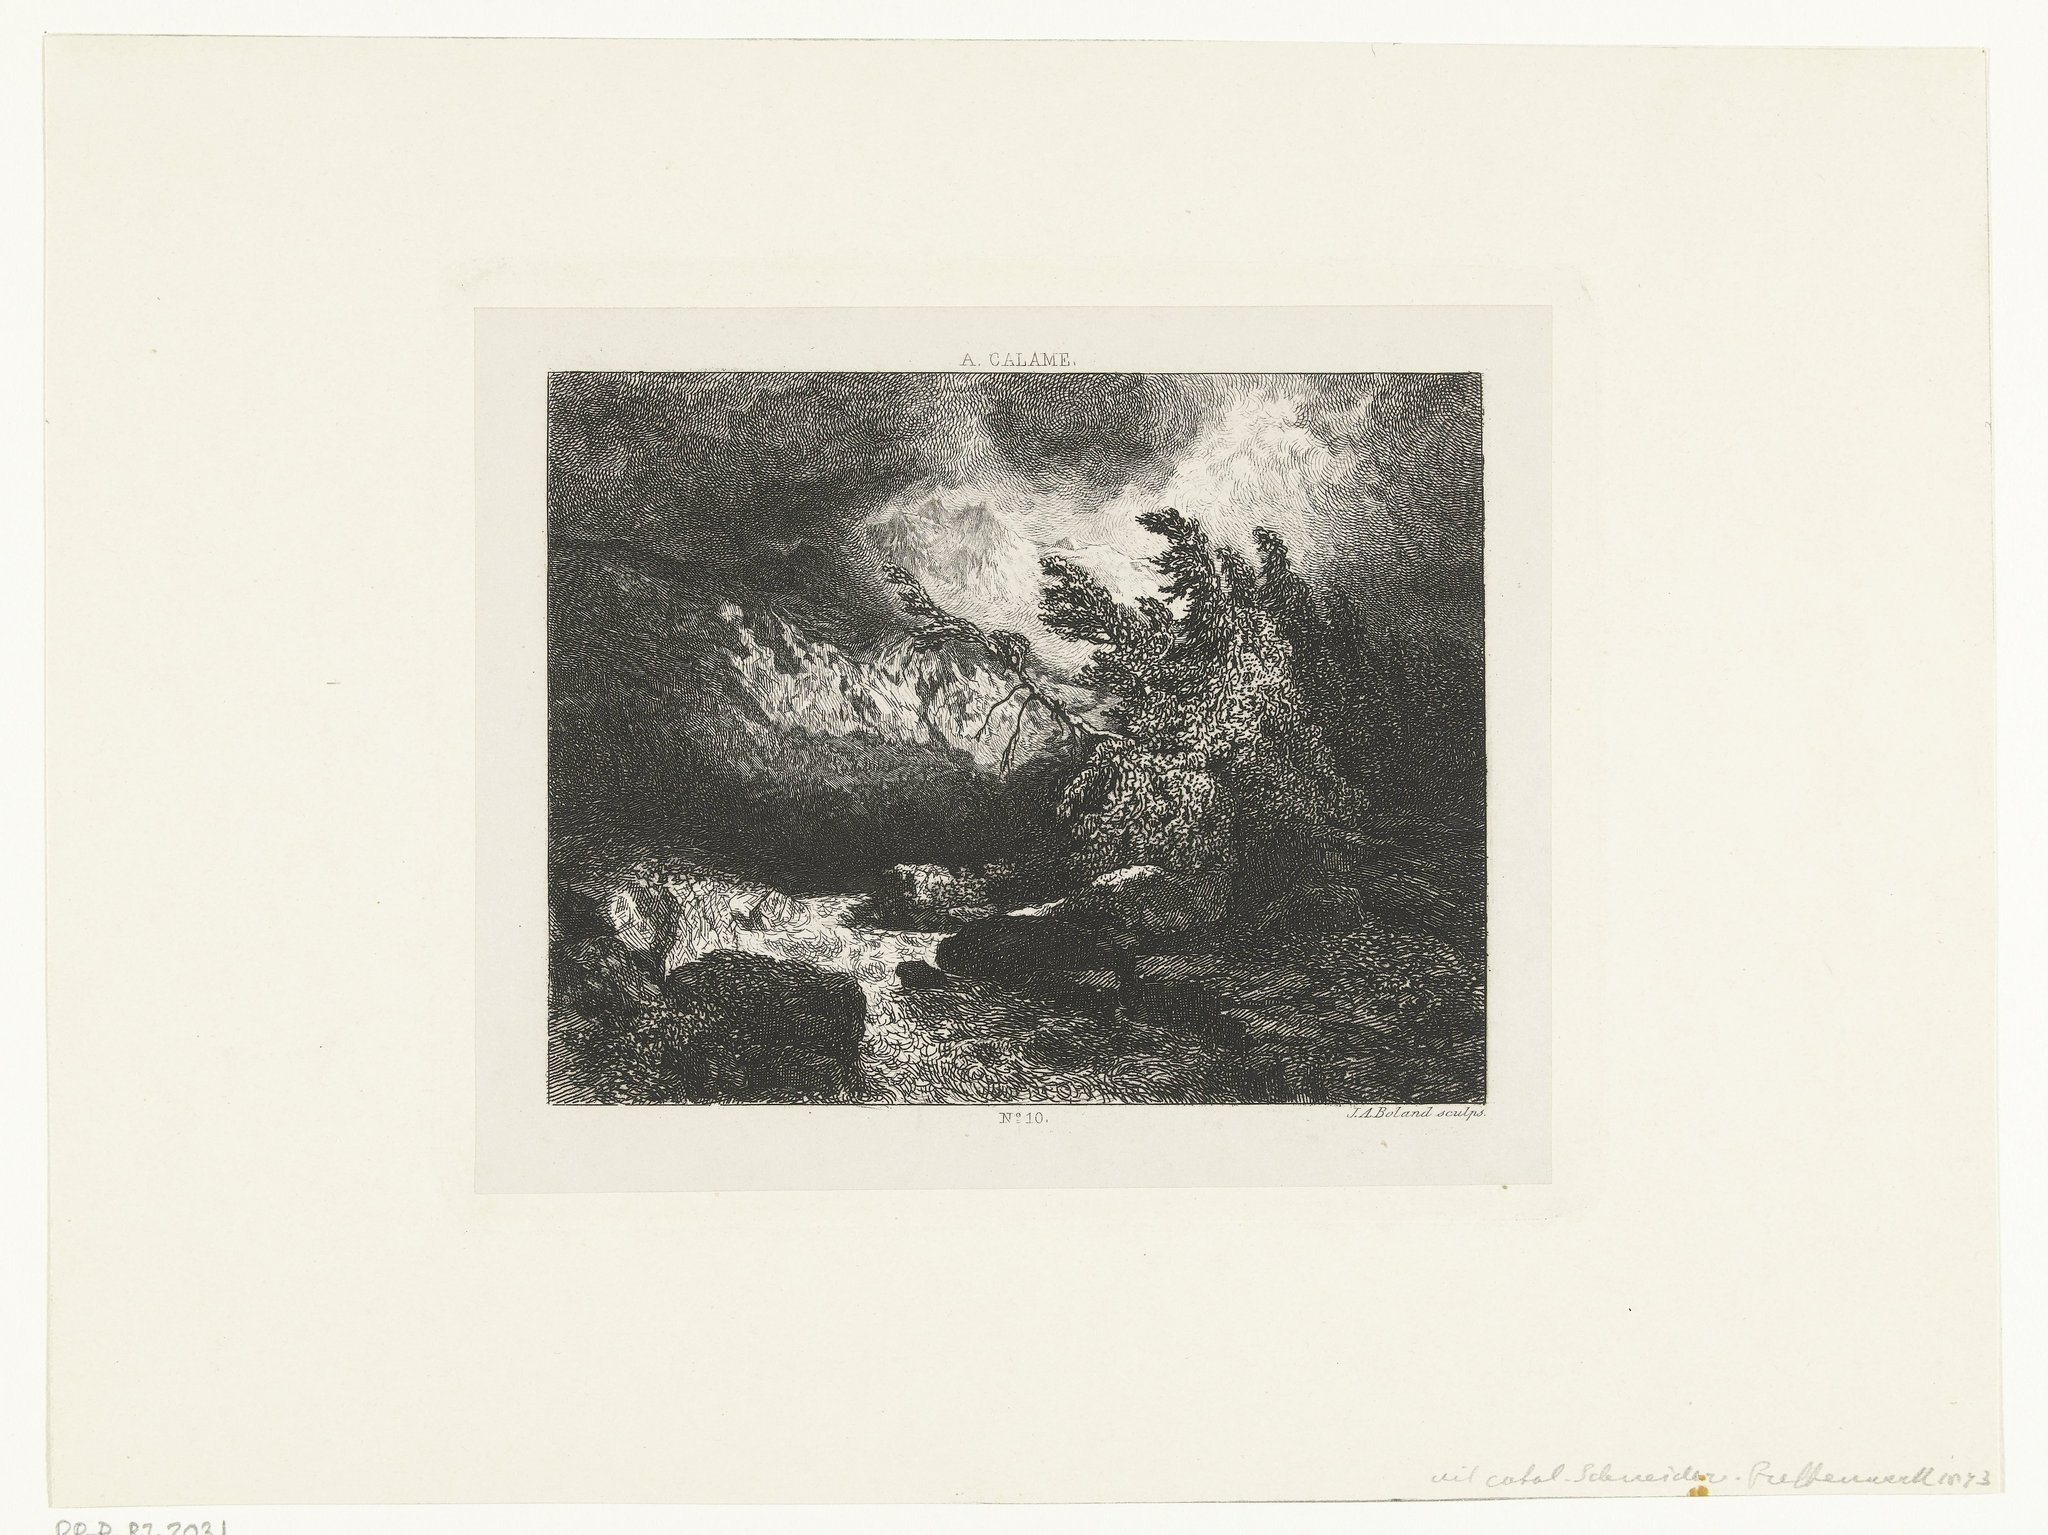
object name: print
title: Landschap met waterval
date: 1860-1900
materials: paper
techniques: etching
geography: amsterdam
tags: waterfall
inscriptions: collector's mark: Lugt 2165